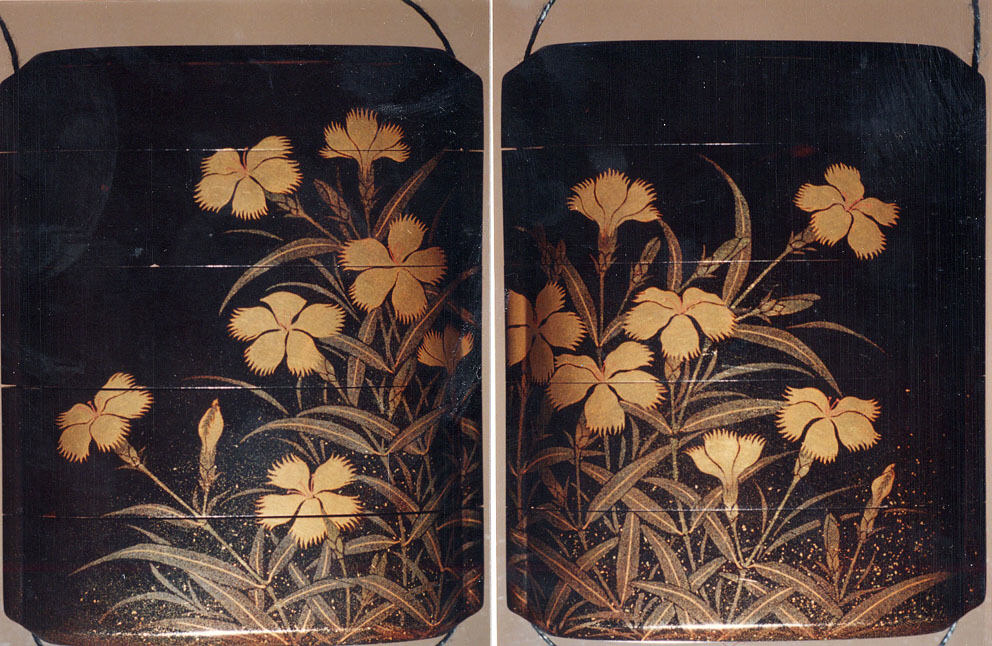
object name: inrō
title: Case (Inrō) with Design of Flowering Carnations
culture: japanese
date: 1701-1900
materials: gold, lacquer, silver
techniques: fundame, roiro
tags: flowers